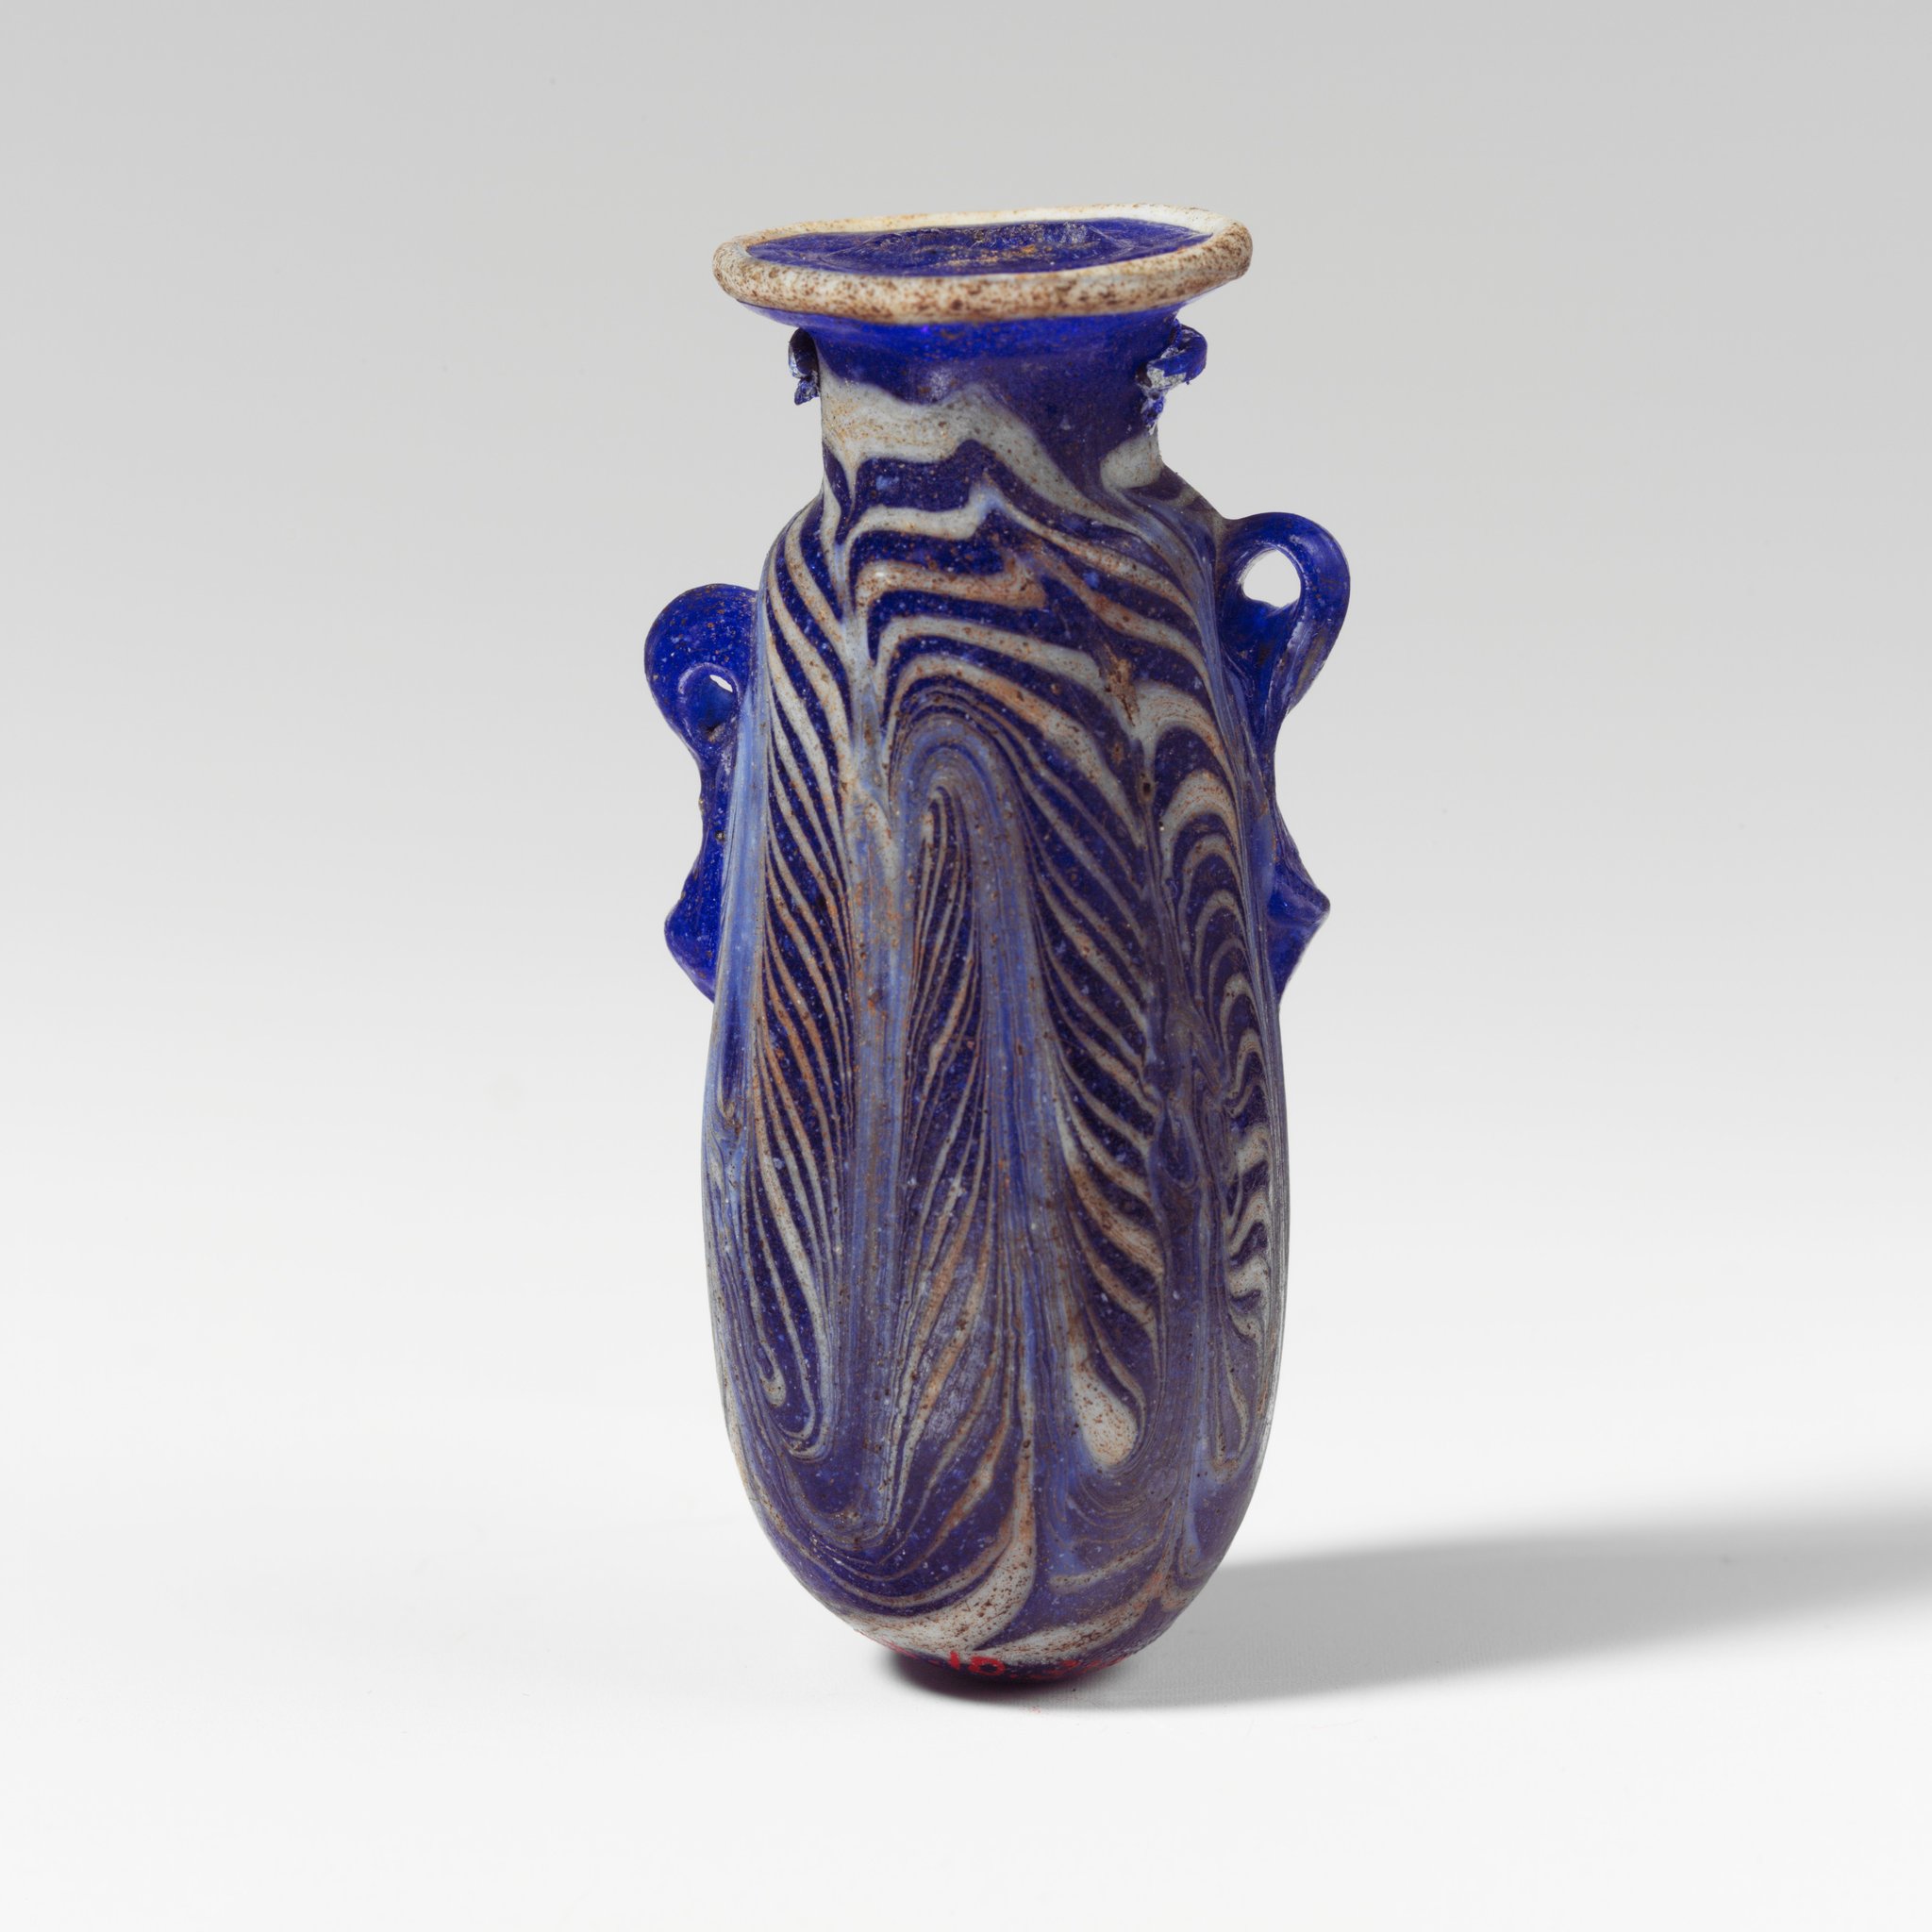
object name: alabastron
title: Glass alabastron (perfume bottle)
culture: greek, eastern mediterranean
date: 534-401 BCE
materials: glass